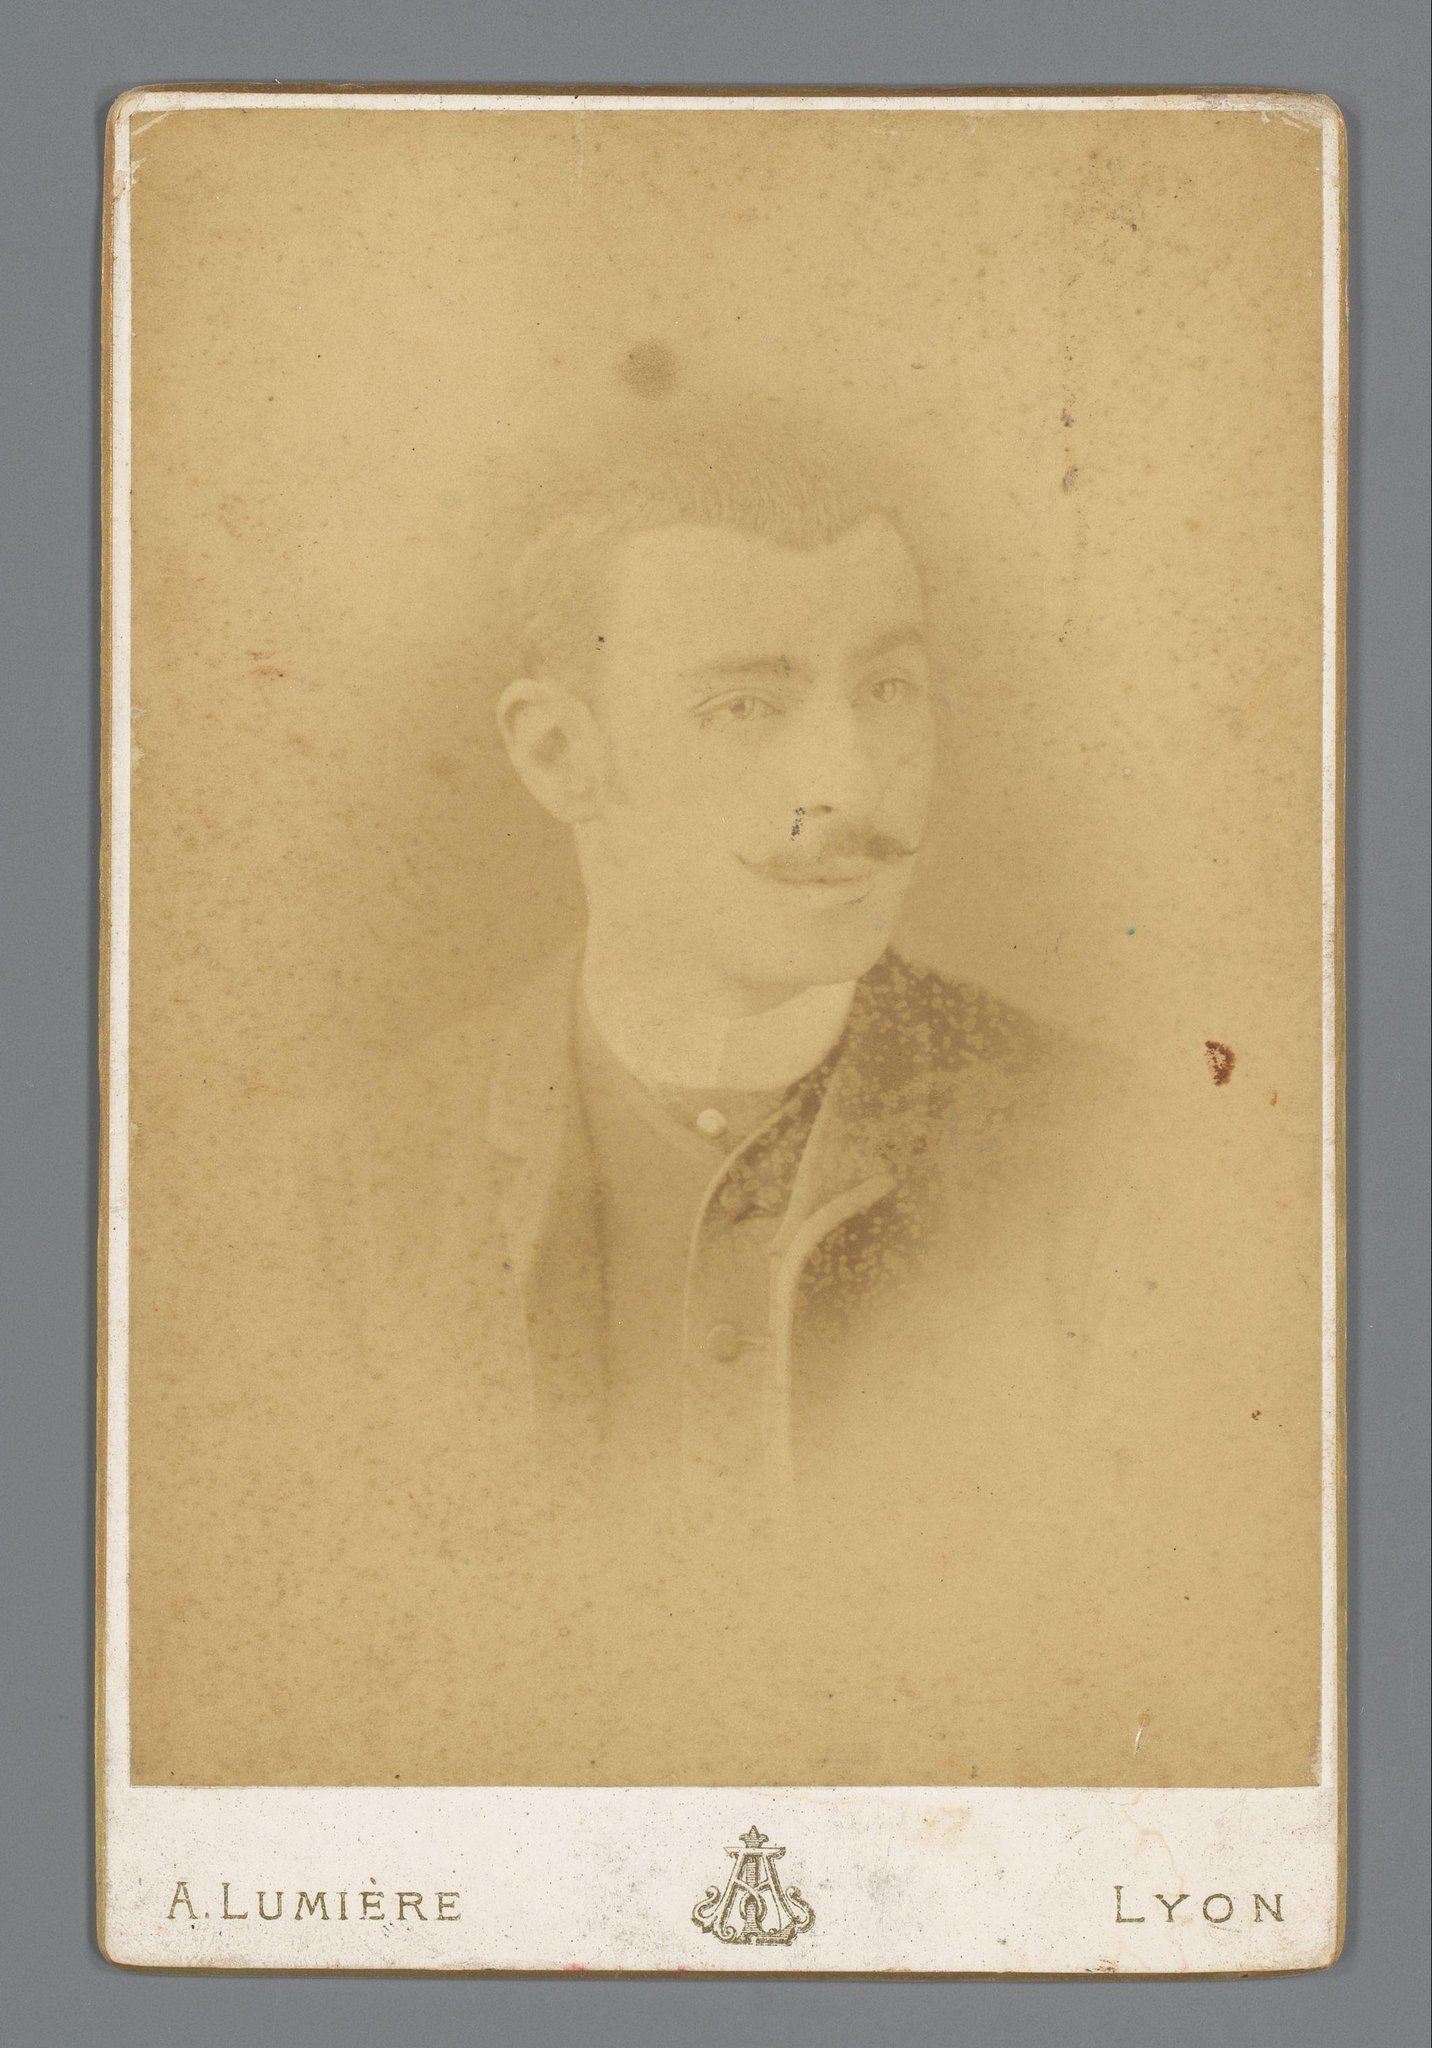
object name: cabinet photograph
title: Portret van een onbekende jonge man met snor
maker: antoine lumière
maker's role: painter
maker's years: 1840-1911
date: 1878-1886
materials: cardboard, paper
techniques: albumen print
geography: lyon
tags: adult man, anonymous historical person portrayed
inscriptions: inscription: ‘MÉDAILLE D'OR/ Exposition Universelle 1878/ Médaille Hors Ligne/ Concours Universel de Photographie/ PARIS 1874/ Lyon/ 2. Rue du Plat, 2/ Maison du Palais Royal/ ci-devant: Rue de la Barre, 16/ MÉDAILLE DE PROGRÈS/ Exposition Universelle de Vienne 1873/ MÉDAILLE D'OR/ Exposition Universelle de Lyon 1872/ Les Clichés étant conservés on peut demander/ des Cartes sans poser de nouveau/ Epreuve obtenue avec un instrument/ de la Maison E. Français de Paris./ H. & F. PARIS’, inscription: ‘A Celle que j'ai tout/ Souvenir [...]/ Ce '10 [...] 86’